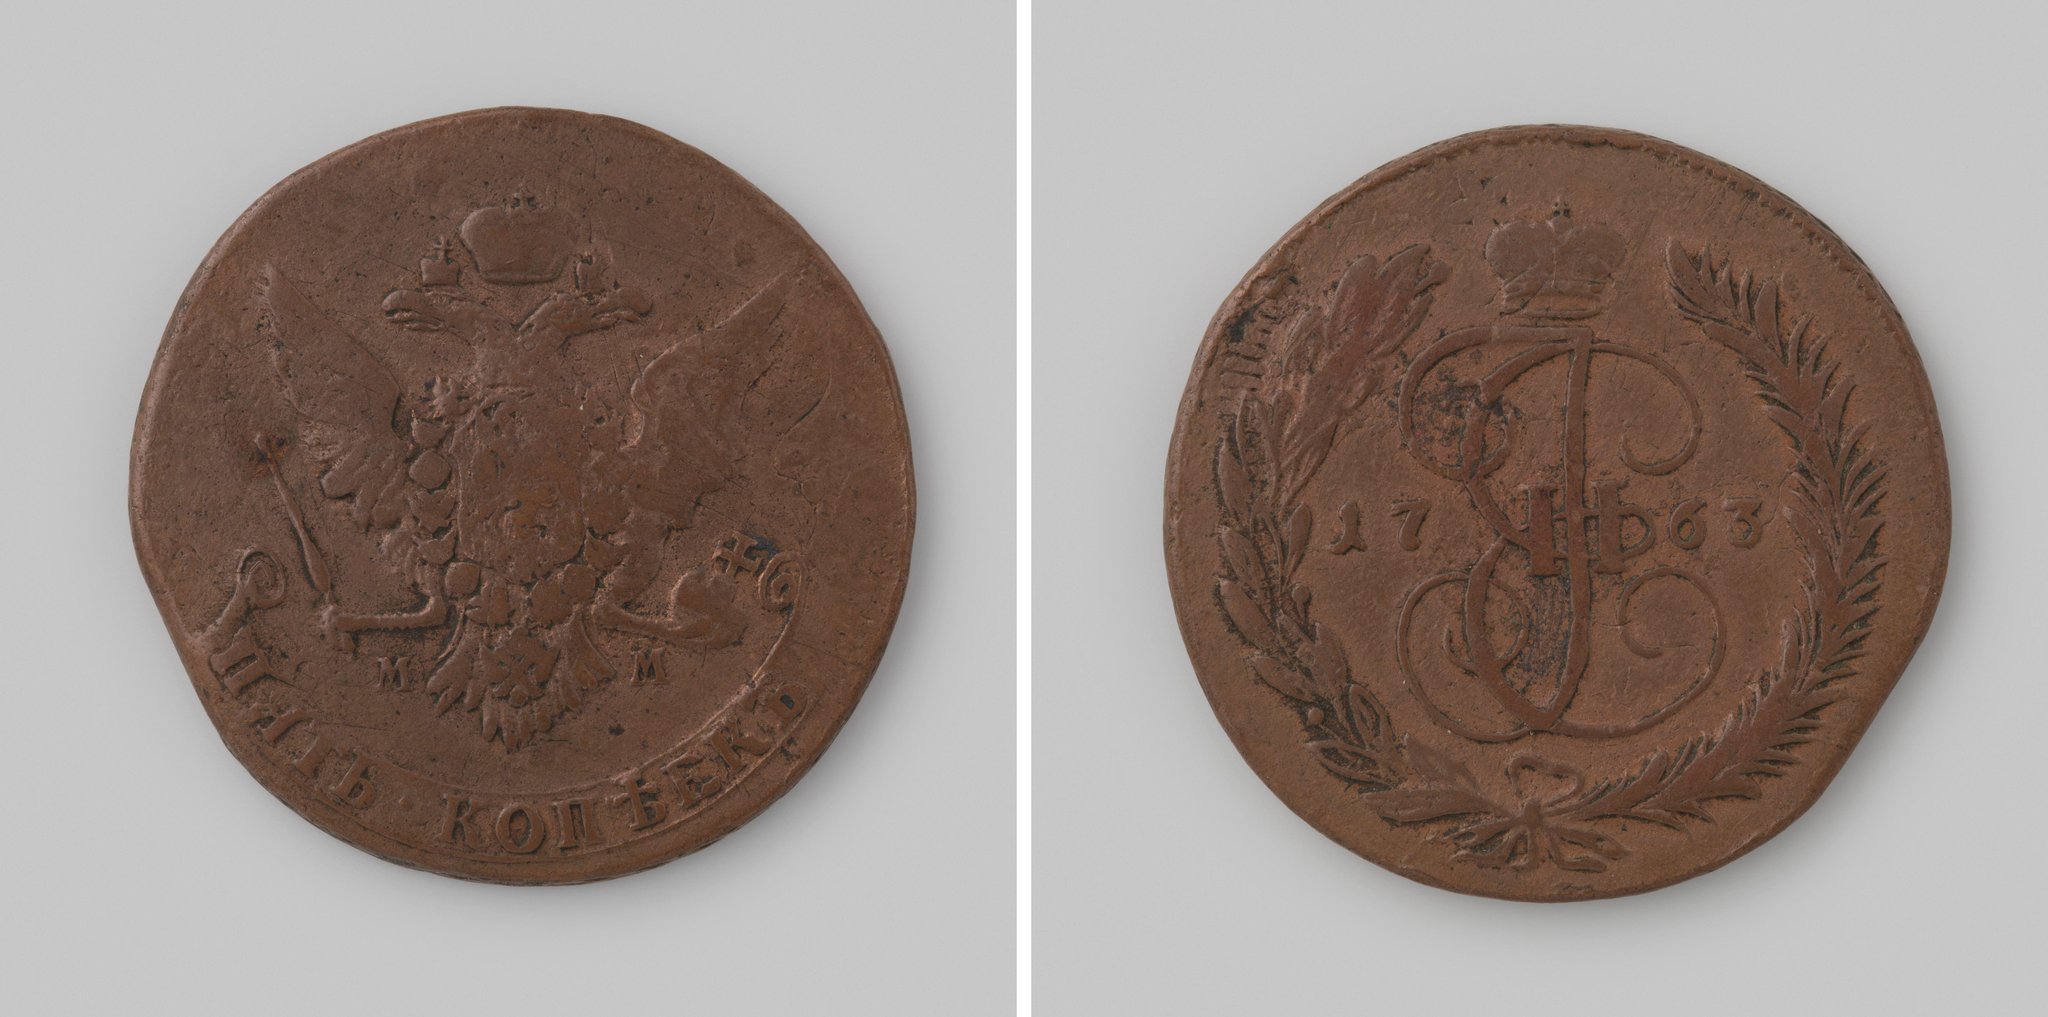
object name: coin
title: Rusland, Catherina II, 5 kopeken, 1763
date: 1763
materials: copper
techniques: striking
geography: moscow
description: Koperen munt. Voorzijde: dubbelkoppige gekroonde adelaar met gespreide vleugels, met op zijn borst door ridderorde omhangen wapenschild en met in zijn poten scepter en bol met daarop kruis. Boven de adelaar een kroon. Links en rechts onder de staart de letters M M [=Moskou]. Onderaan op een banderol waarde-aanduiding. Keerzijde: binnen twee samengebonden takken tussen het jaartal gekroond monogram van de czarina. Kabelrand.